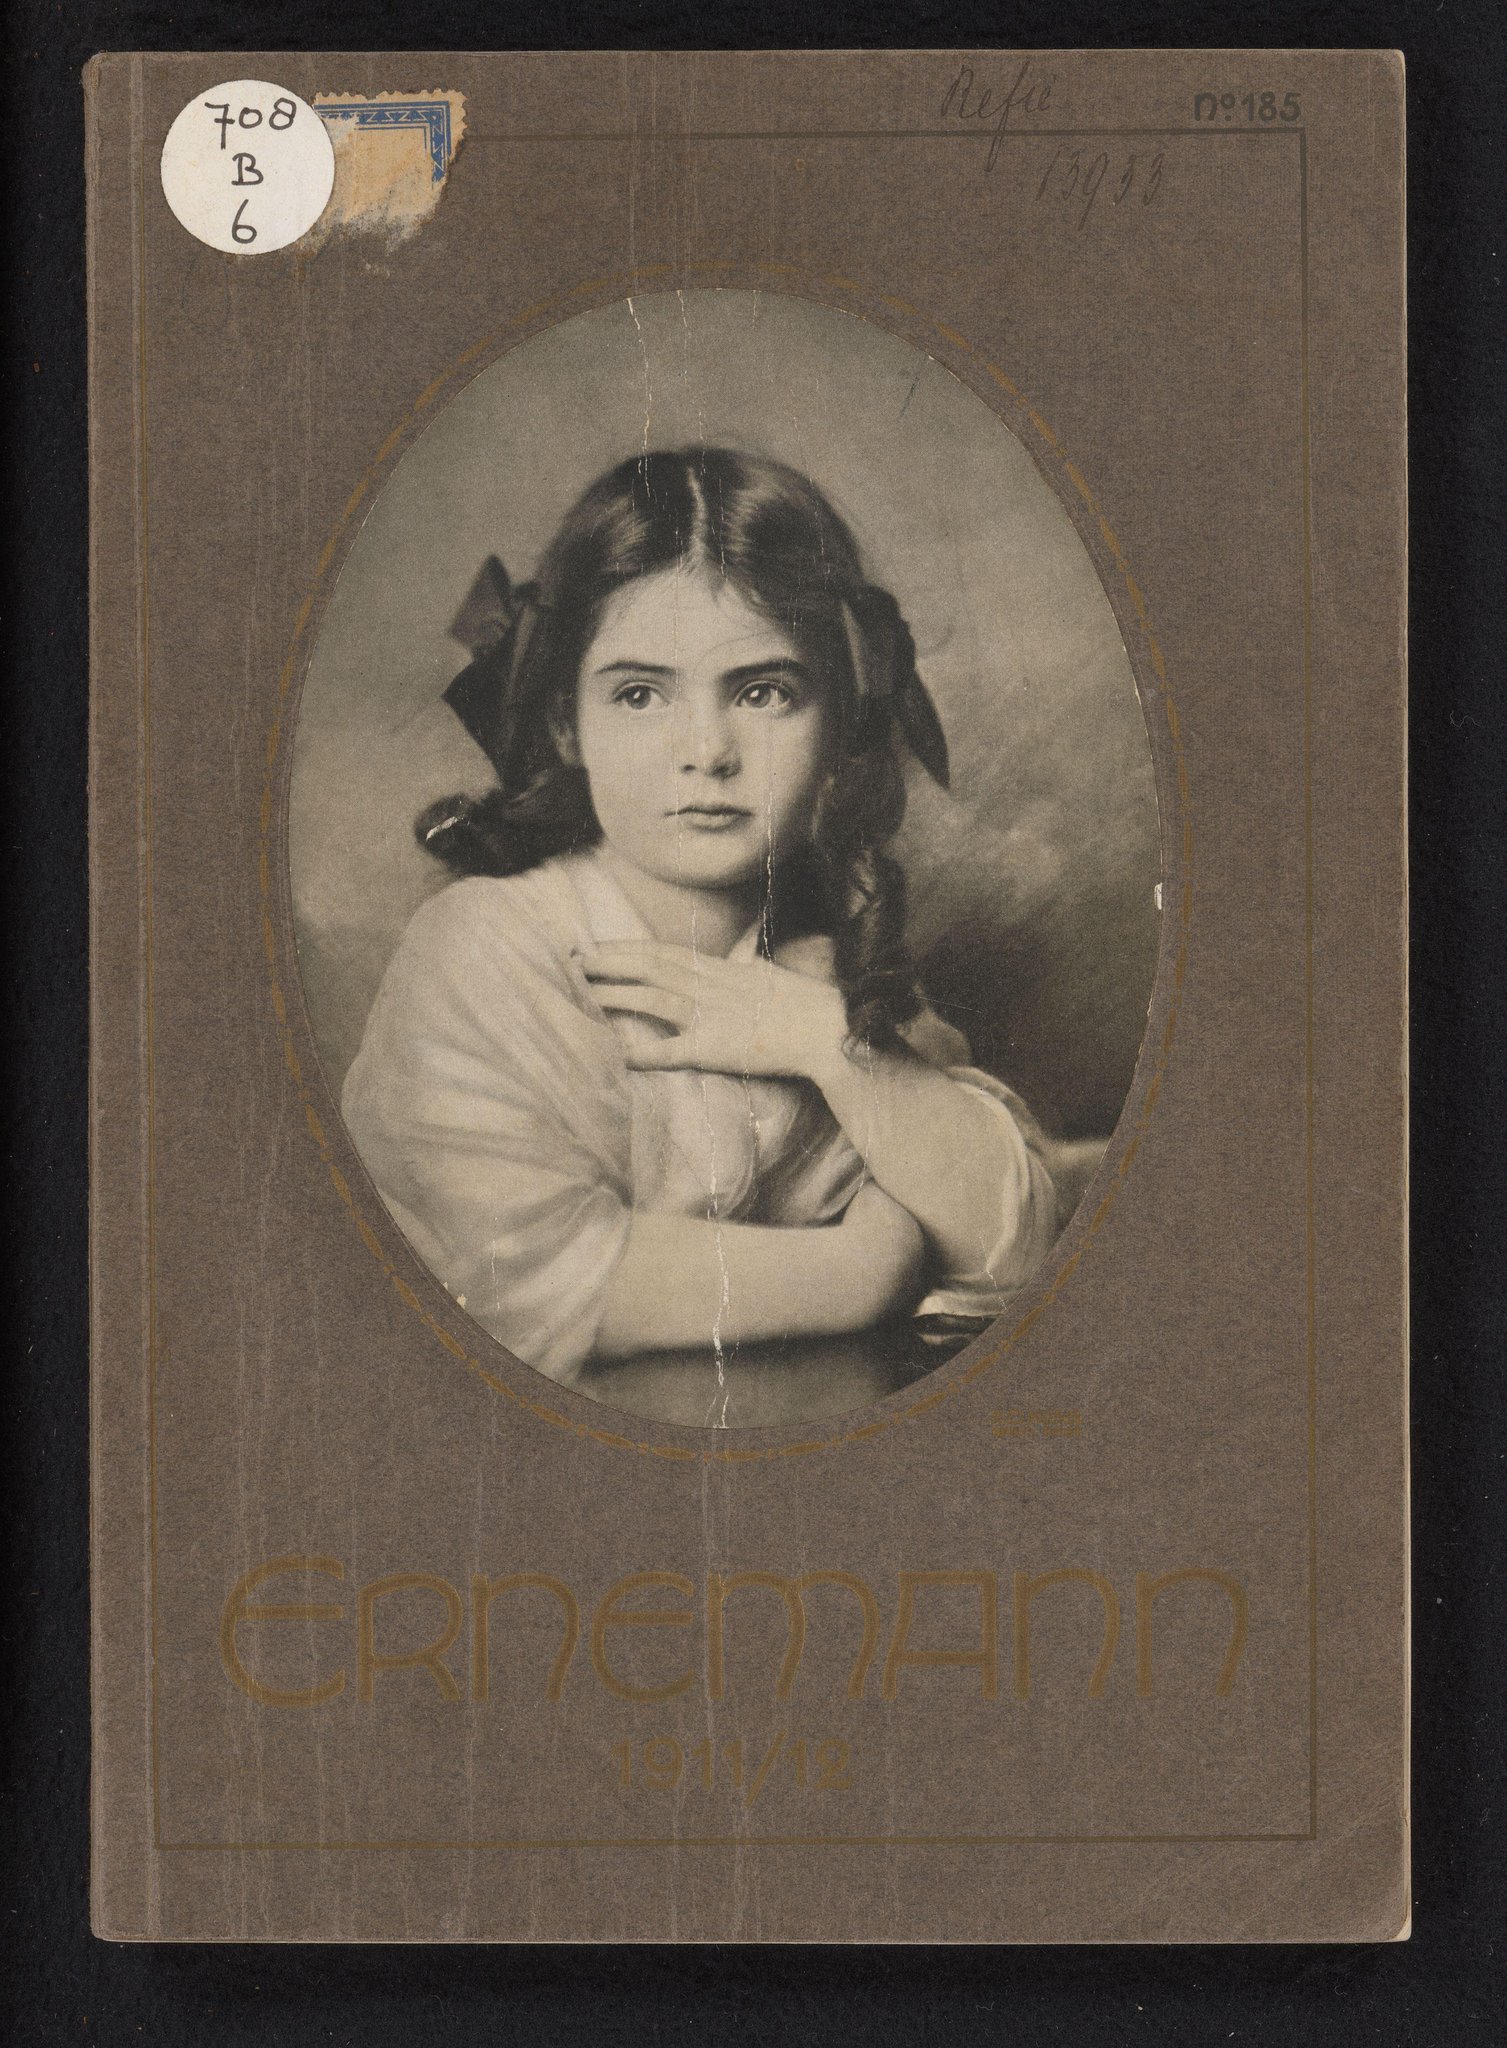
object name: photomechanical print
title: Portret van een onbekend meisje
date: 1907-1912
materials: paper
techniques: autotype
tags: girl (child between toddler and youth), anonymous historical person portrayed